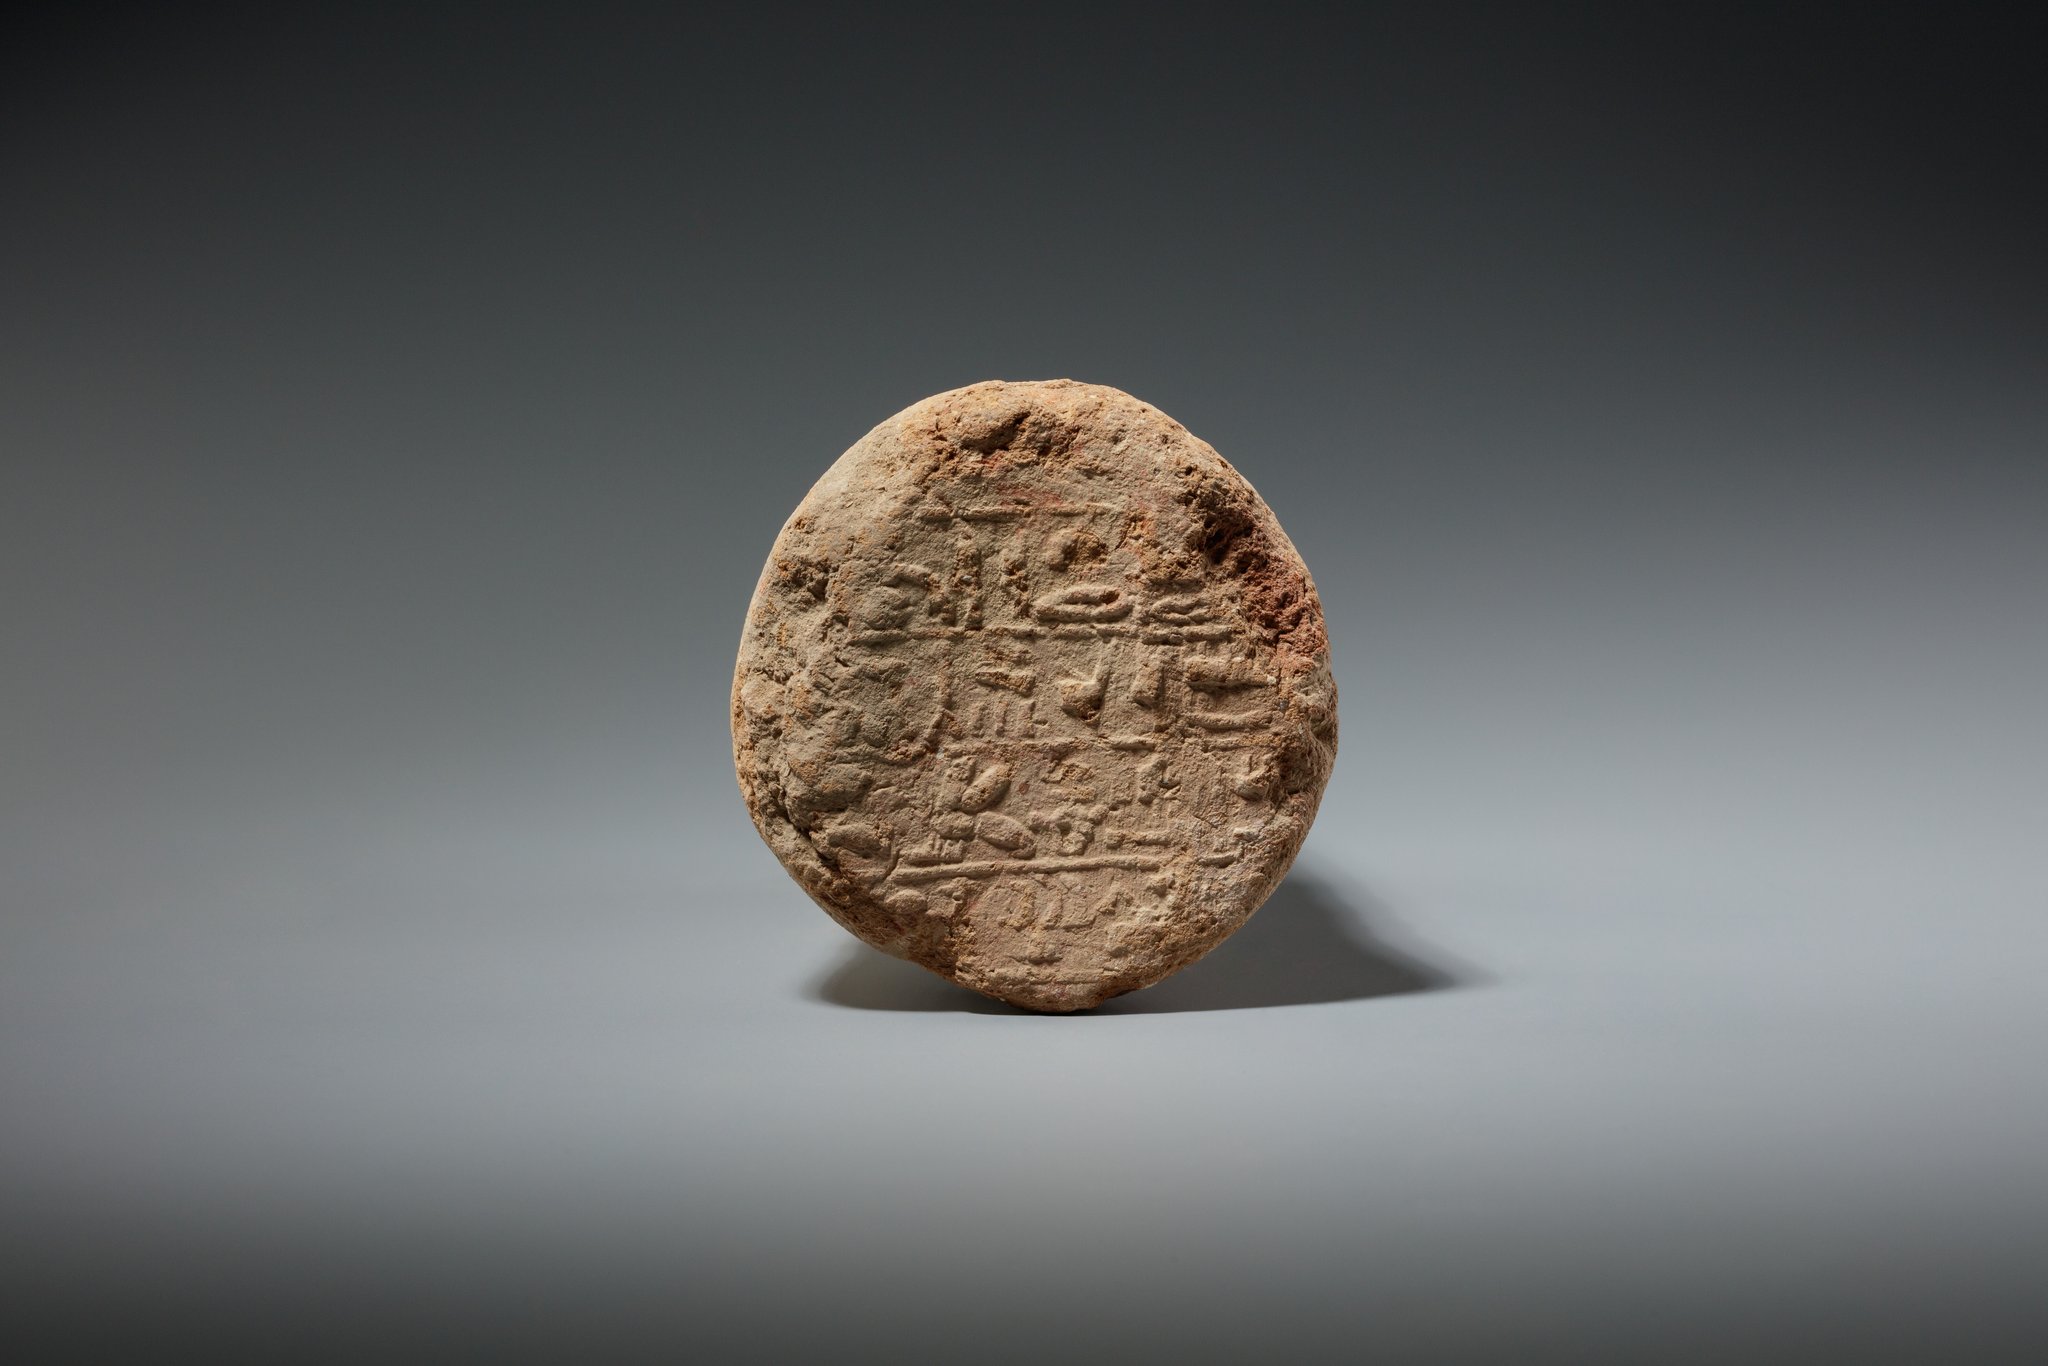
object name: cone, davy 405, neferkhawet, wab priest, bee keeper, amun, field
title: Funerary Cone of the Wab-Priest Neferkhawet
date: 1550-1295 BCE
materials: pottery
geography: egypt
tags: hieroglyphs